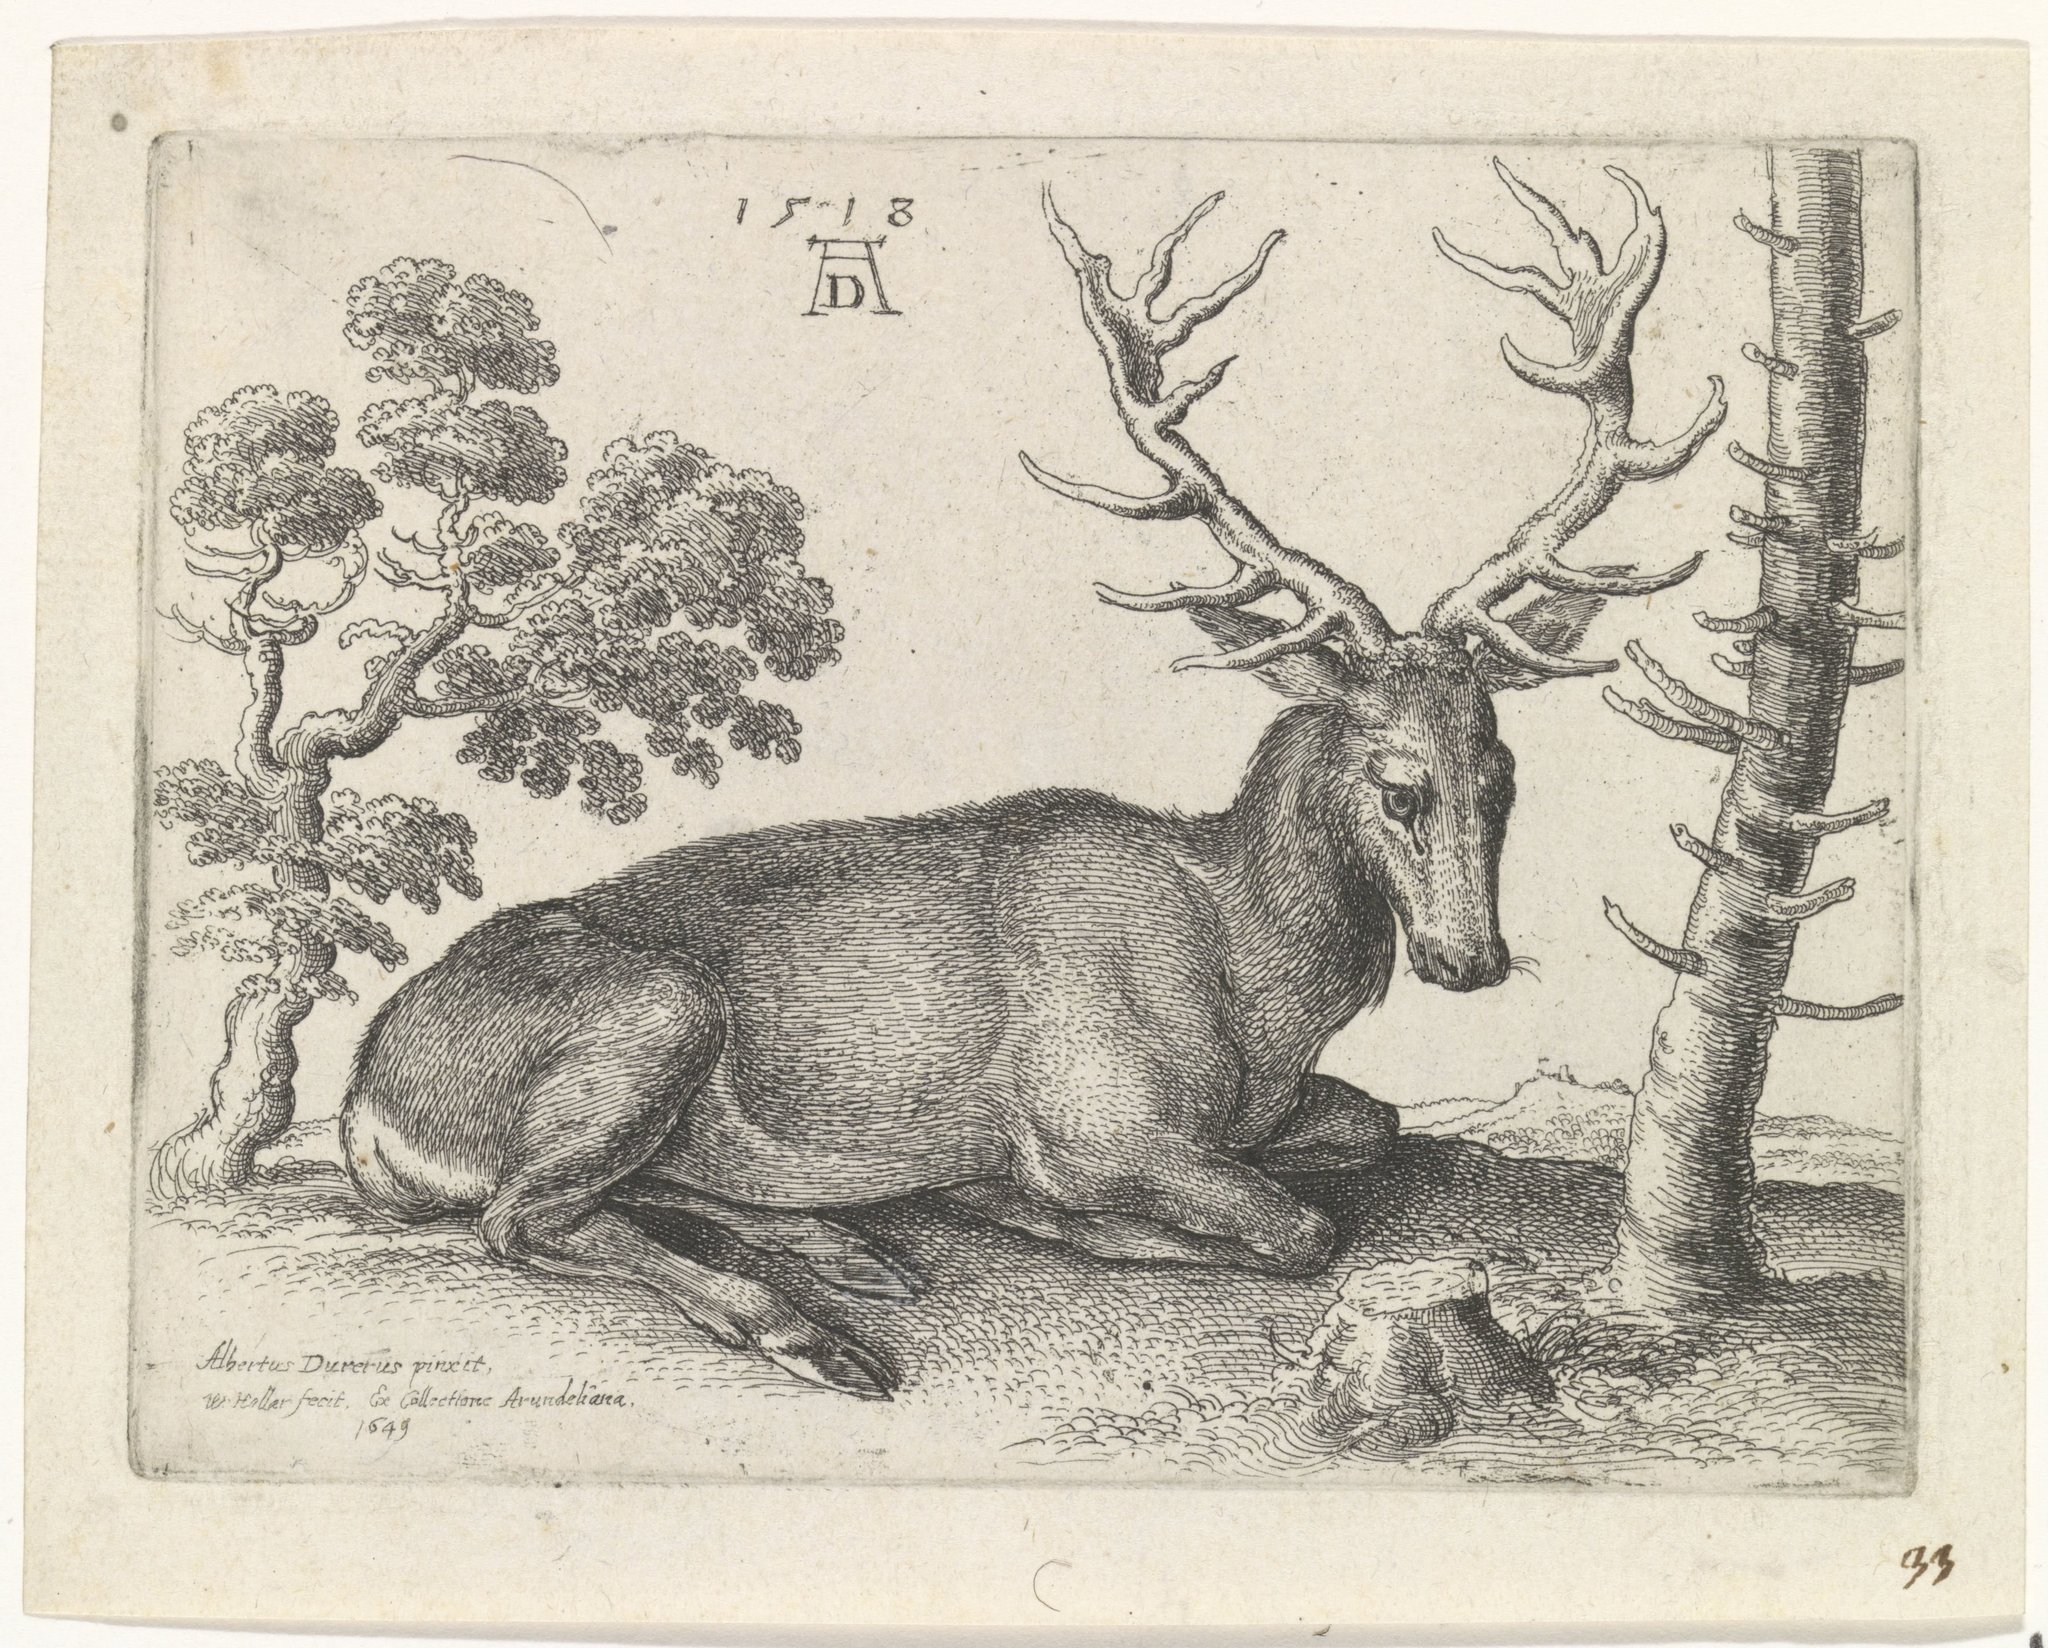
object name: print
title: Liggend hert, naar rechts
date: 1649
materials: paper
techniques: etching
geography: antwerp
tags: hoofed animals: deer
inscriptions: collector's mark: Lugt 240